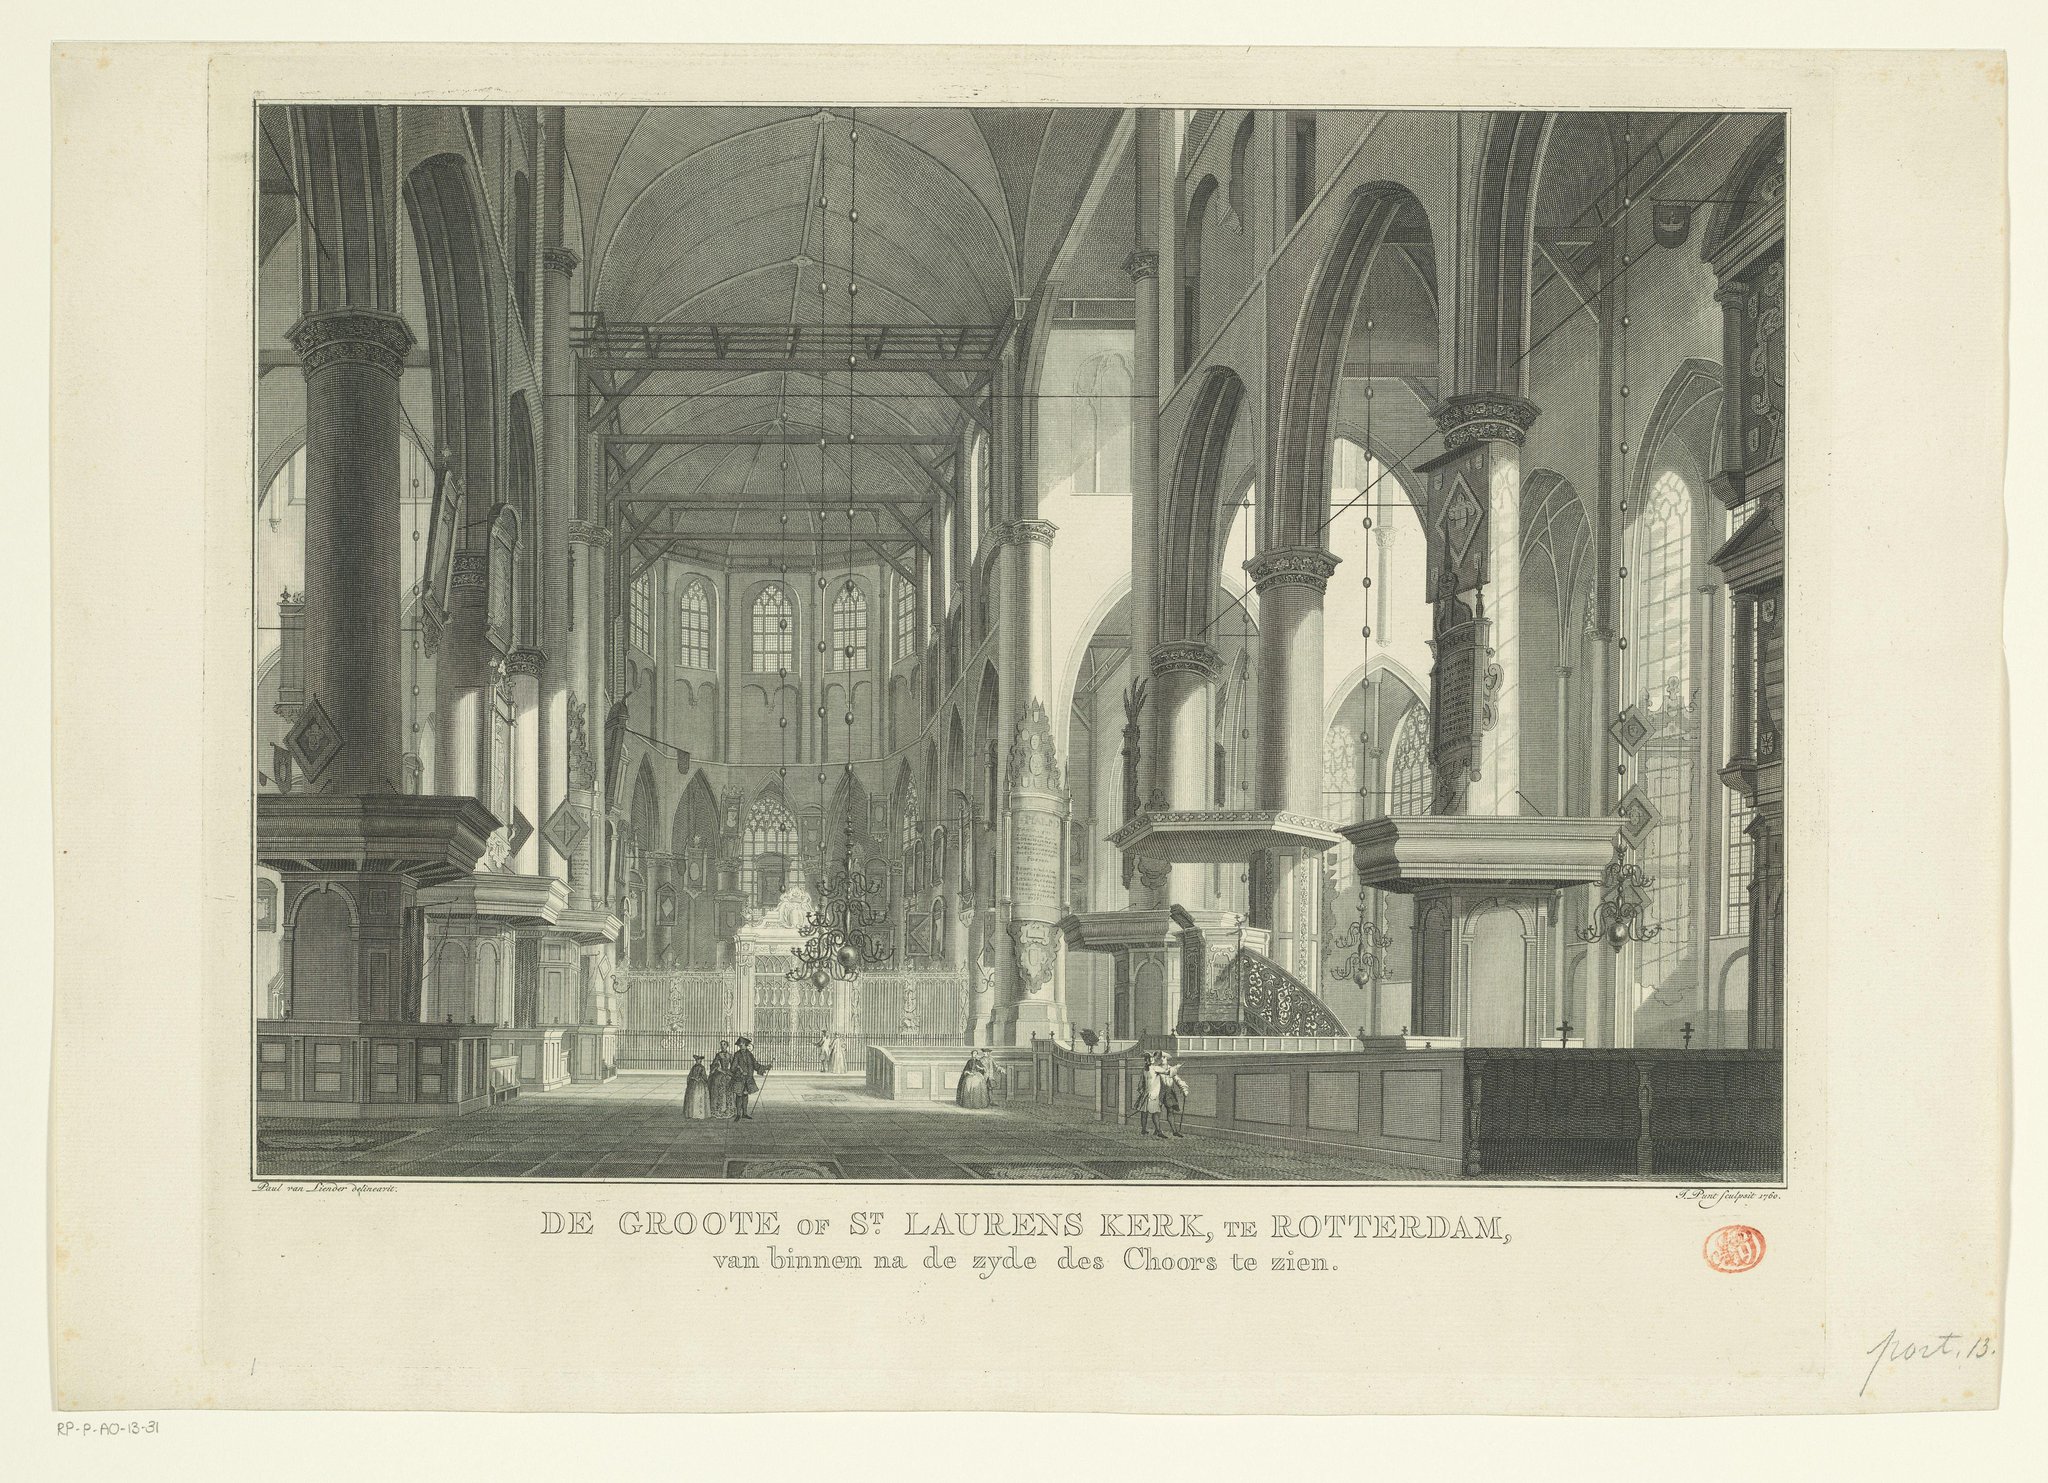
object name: print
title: De Groote of St. Laurens Kerk, te Rotterdam, van binnen na de zyde des choors te zien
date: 1760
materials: paper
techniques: engraving, etching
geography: amsterdam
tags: interior of church, parts of church interior: choir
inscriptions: collector's mark: Lugt 195, collector's mark: Lugt 2228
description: Interieur van de Grote of Sint-Laurenskerk te Rotterdam, gezien in de richting van het koor. In de kerk staan enkele figuren.